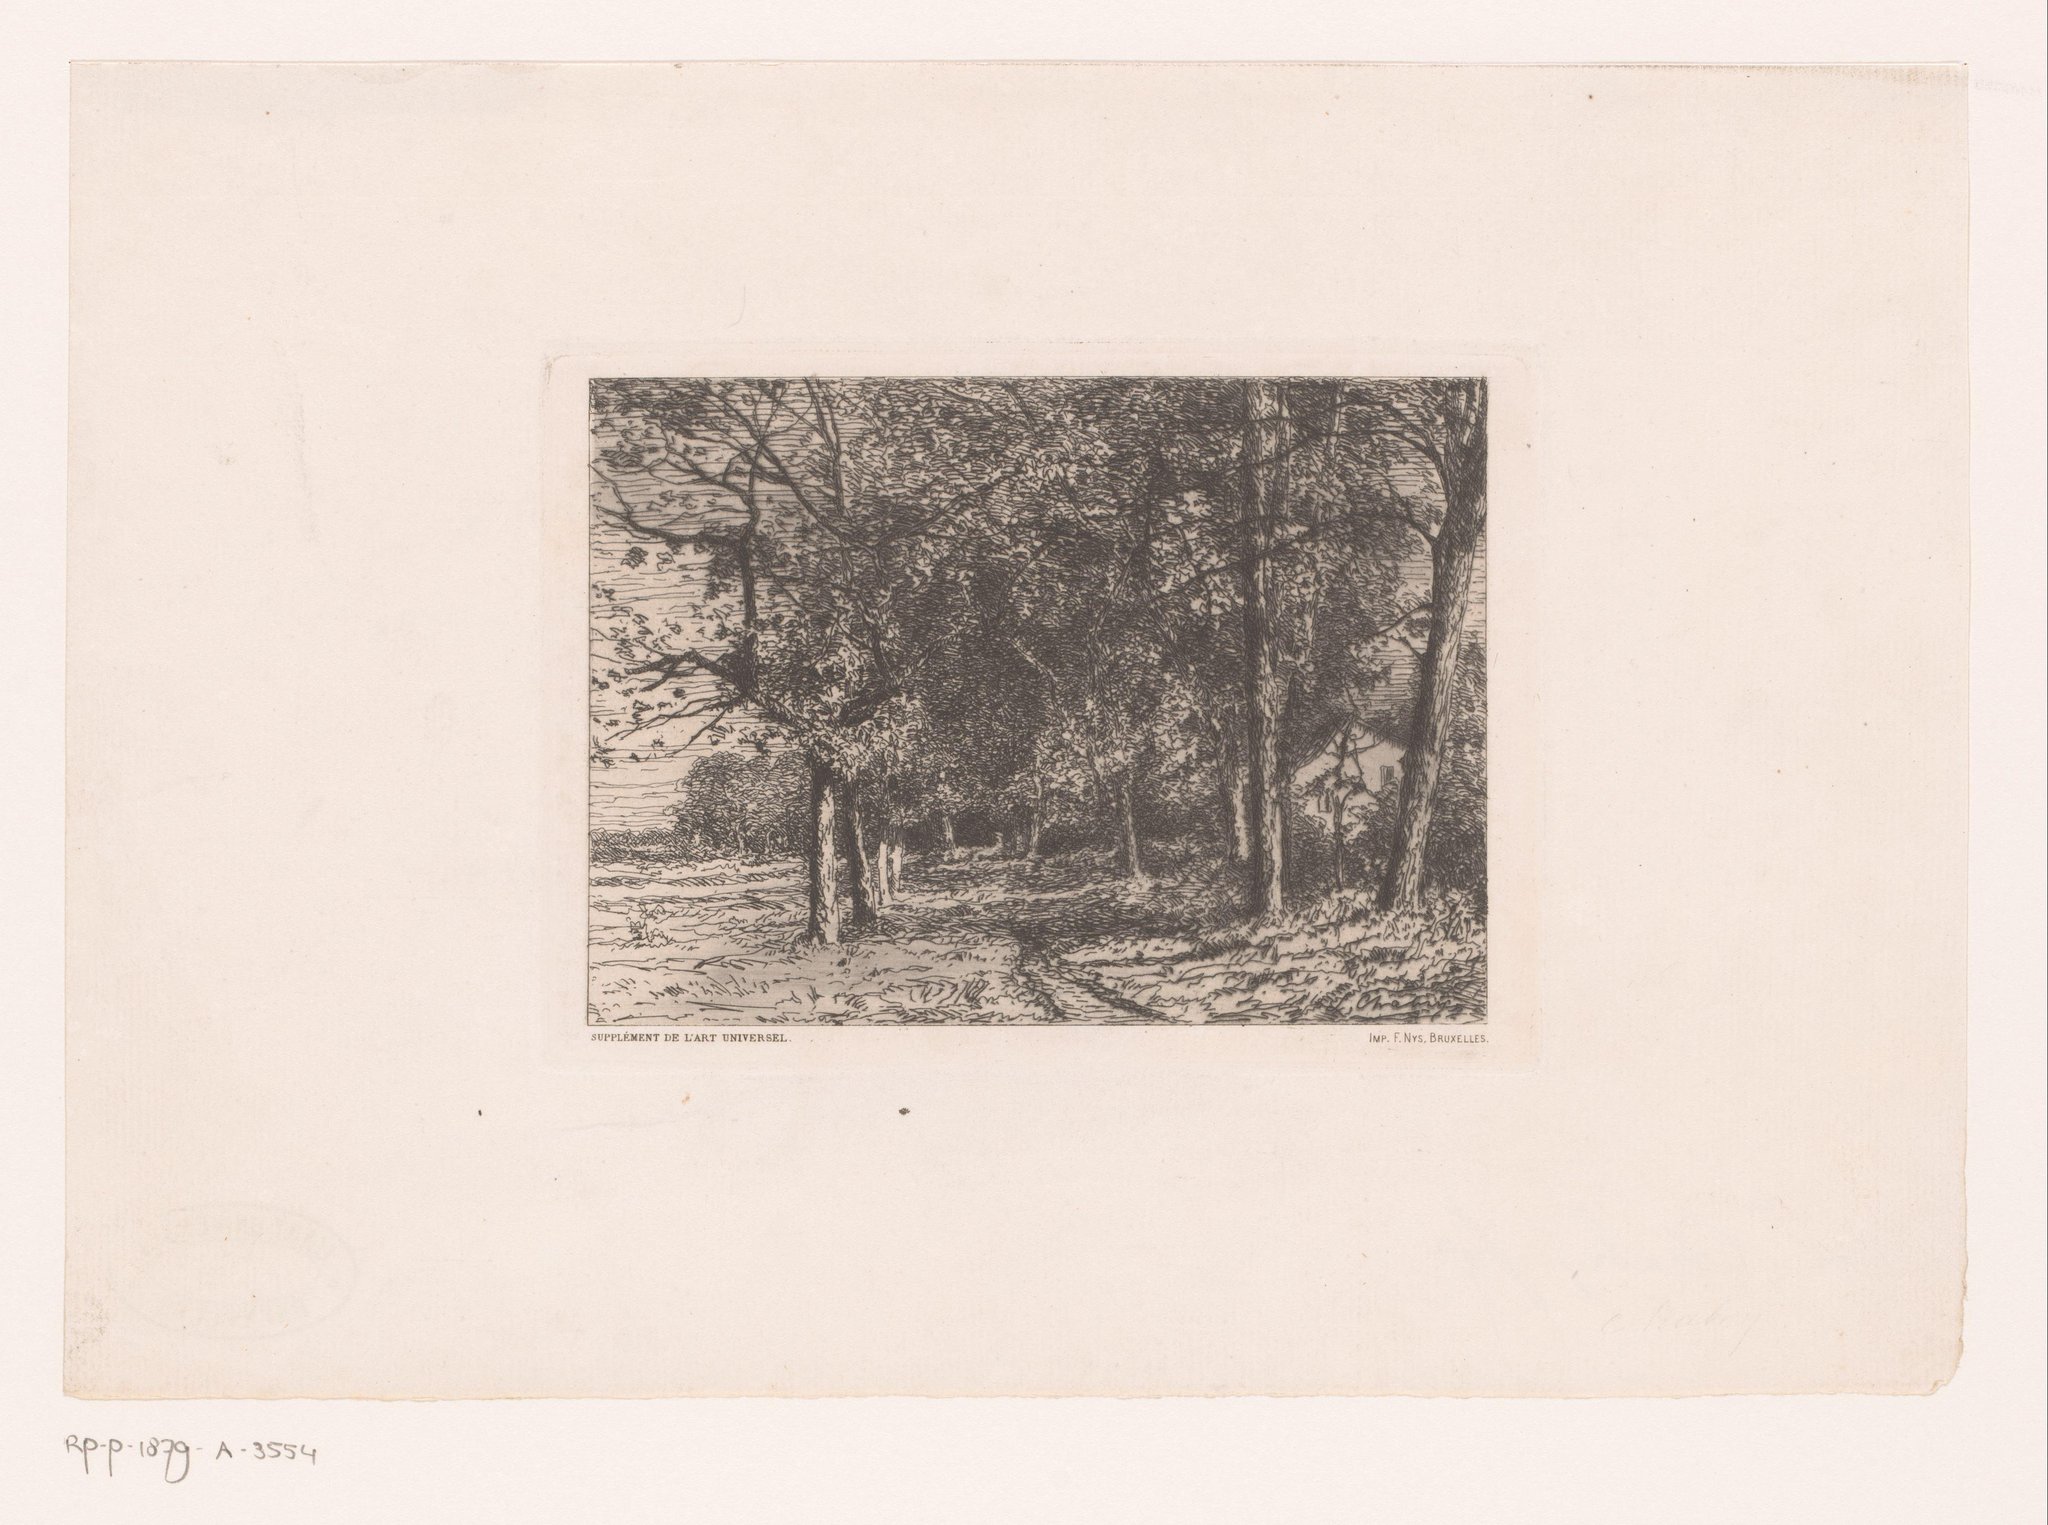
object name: print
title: Bebost landschap met een laan en rechts een huis tussen de bomen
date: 1873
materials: paper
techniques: drypoint, etching, intaglio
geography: brussels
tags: farm or solitary house in landscape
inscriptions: collector's mark: Lugt 3073, collector's mark: Lugt 2228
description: Deze prent is een van de prenten uit de tweede van de jaarlijks uitgegeven prentbijlagen bij L'Art Universel (1873).